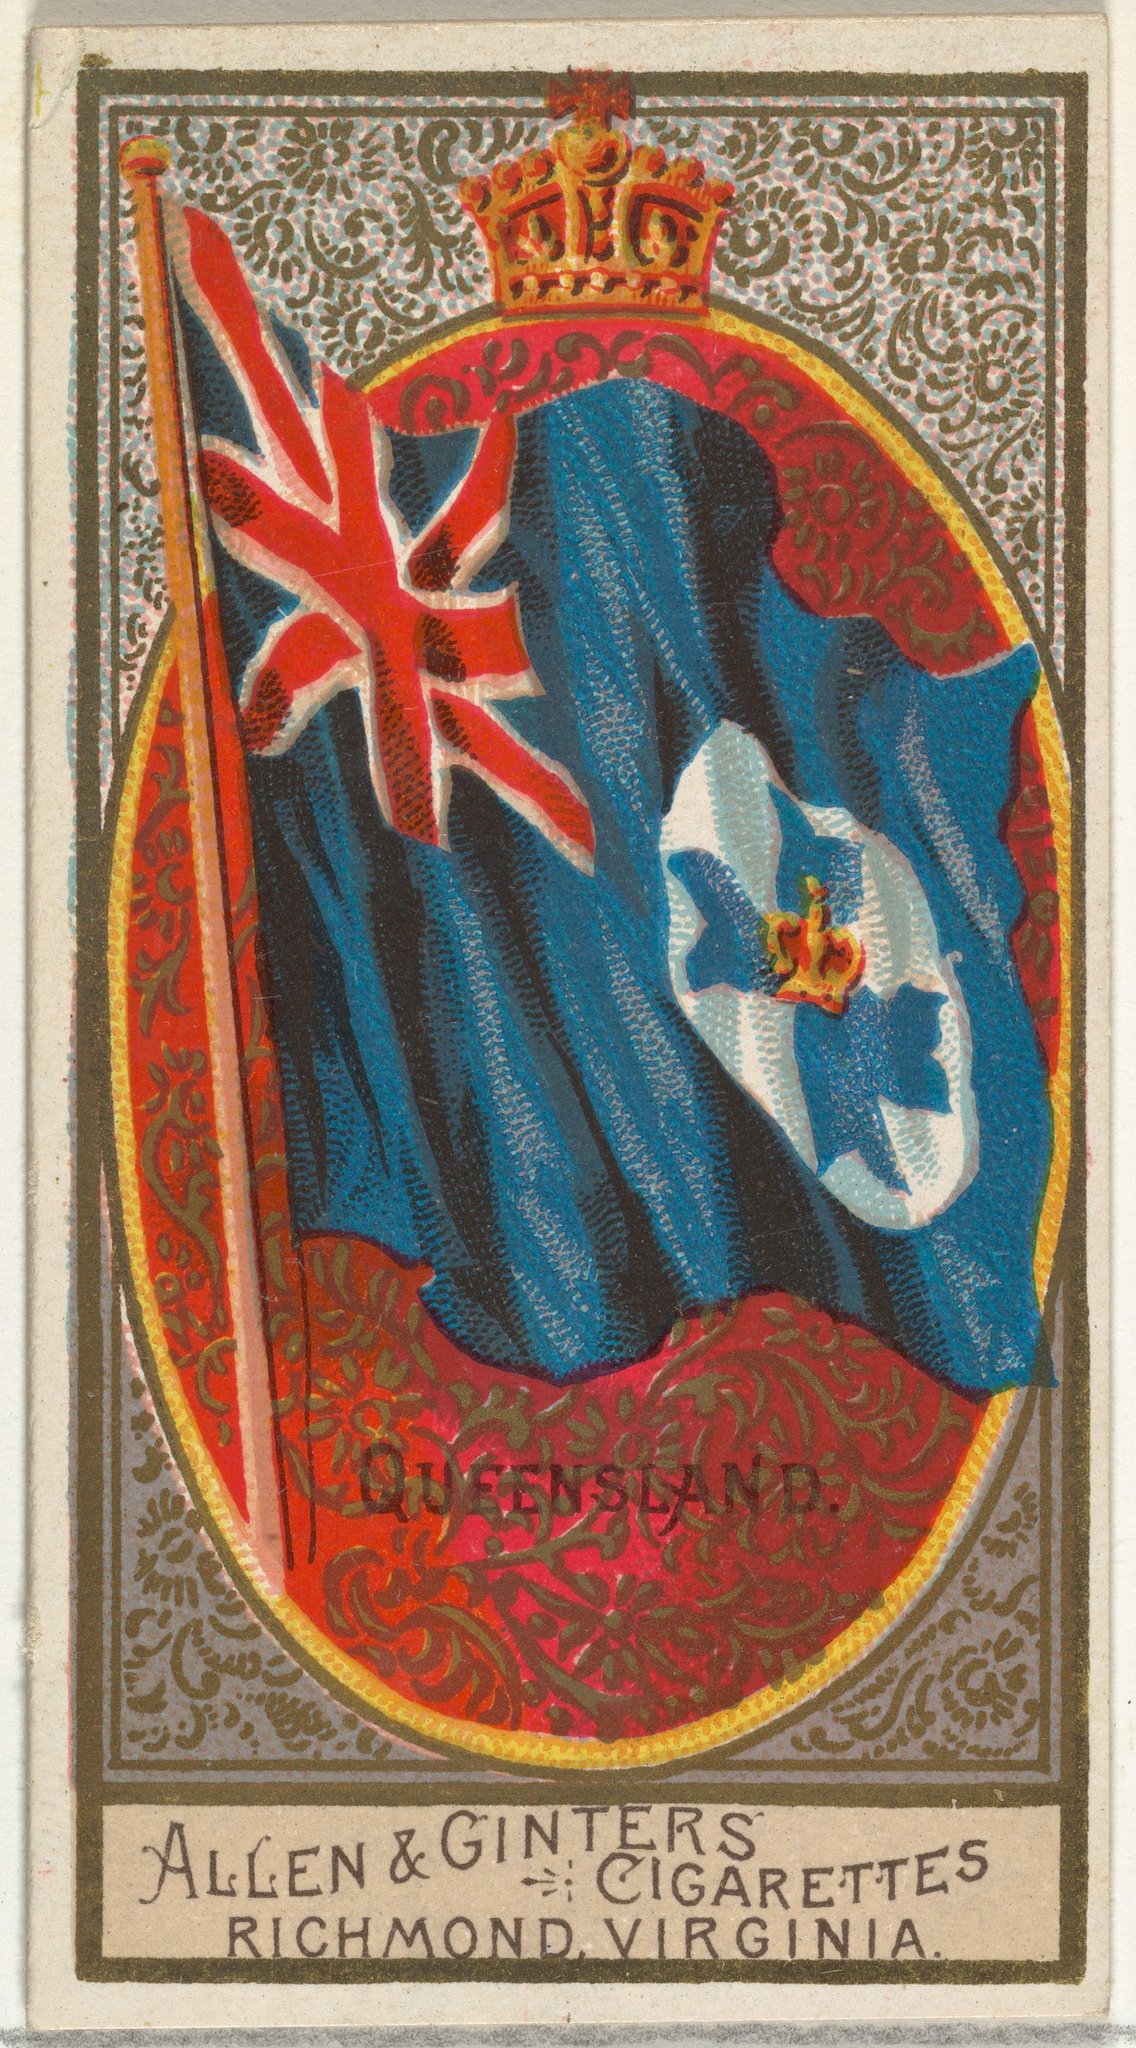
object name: print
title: Queensland, from Flags of All Nations, Series 2 (N10) for Allen & Ginter Cigarettes Brands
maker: allen & ginter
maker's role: publisher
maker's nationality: american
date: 1890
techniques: color lithograph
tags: flags